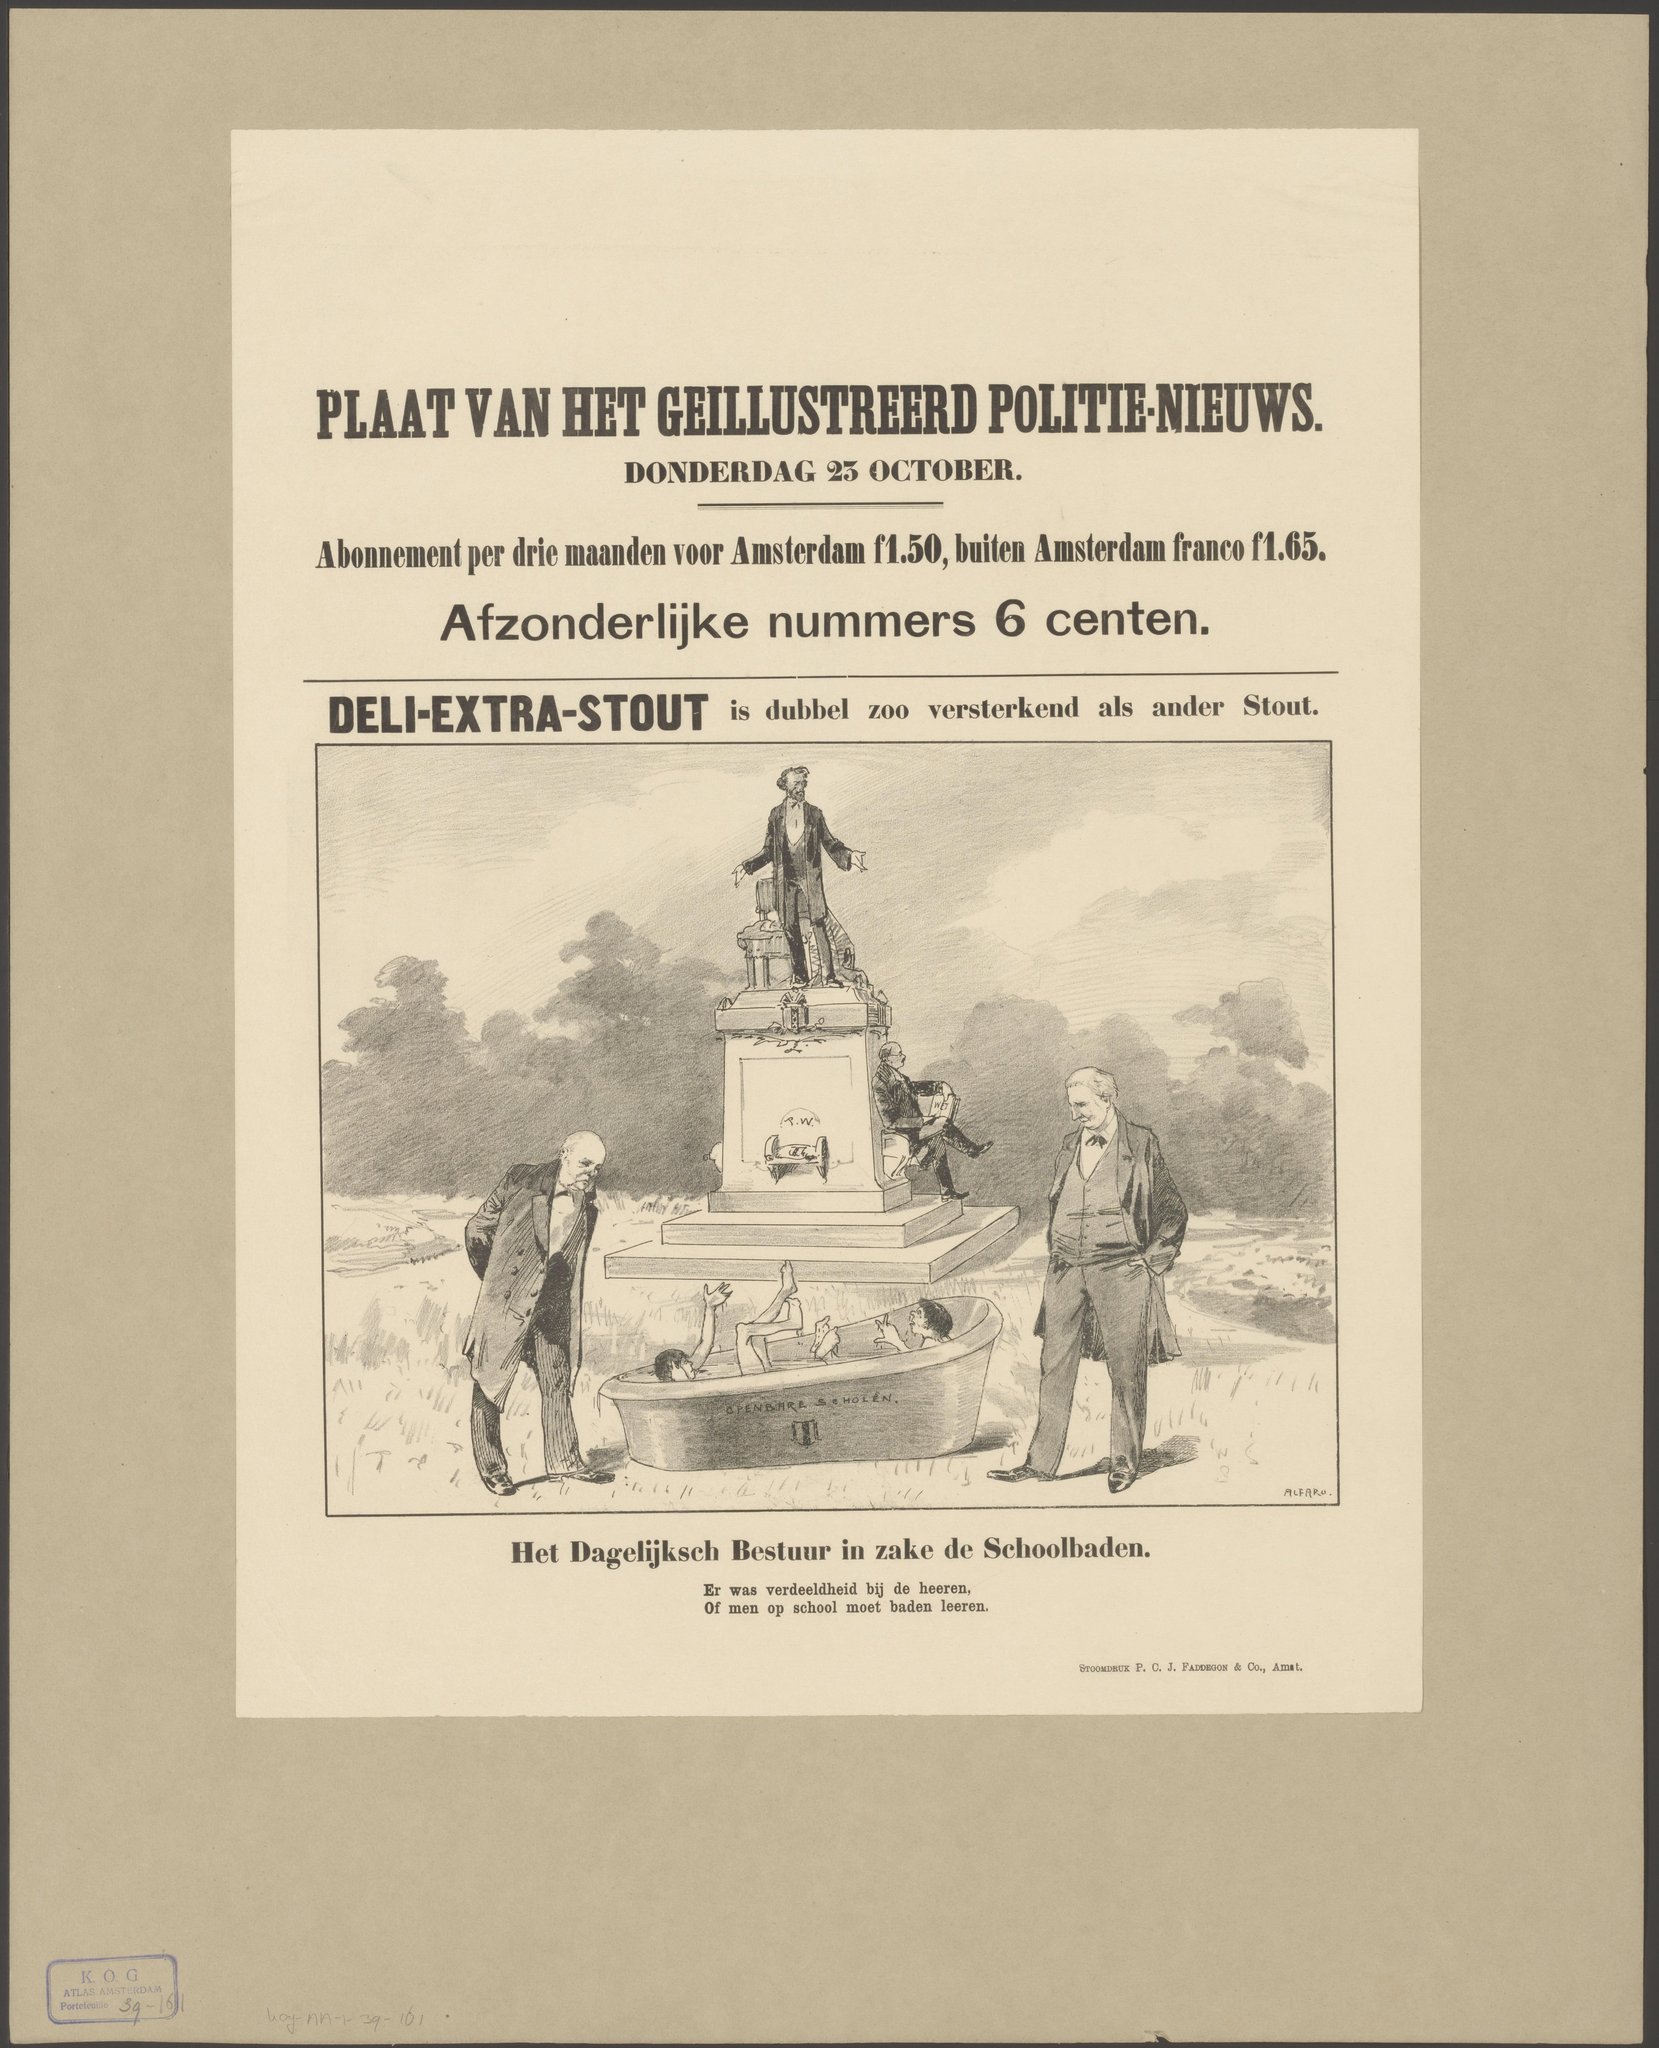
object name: cartoon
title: Het Dagelijksch Bestuur in zake de Schoolbaden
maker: alfaro reijding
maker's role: draughtsman, engineer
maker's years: 1863-1930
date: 1890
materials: paper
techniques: letterpress printing, lithograph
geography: amsterdam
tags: mayor, gijsbert van tienhoven, tub-bath, political caricatures and satires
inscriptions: collector's mark: Lugt 1641b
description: Onderwerpsrubriek binnen de Atlas Amsterdam: Armwezen en liefdadige instellingen: IV. Prenten betrekking hebbende op Philantropie.